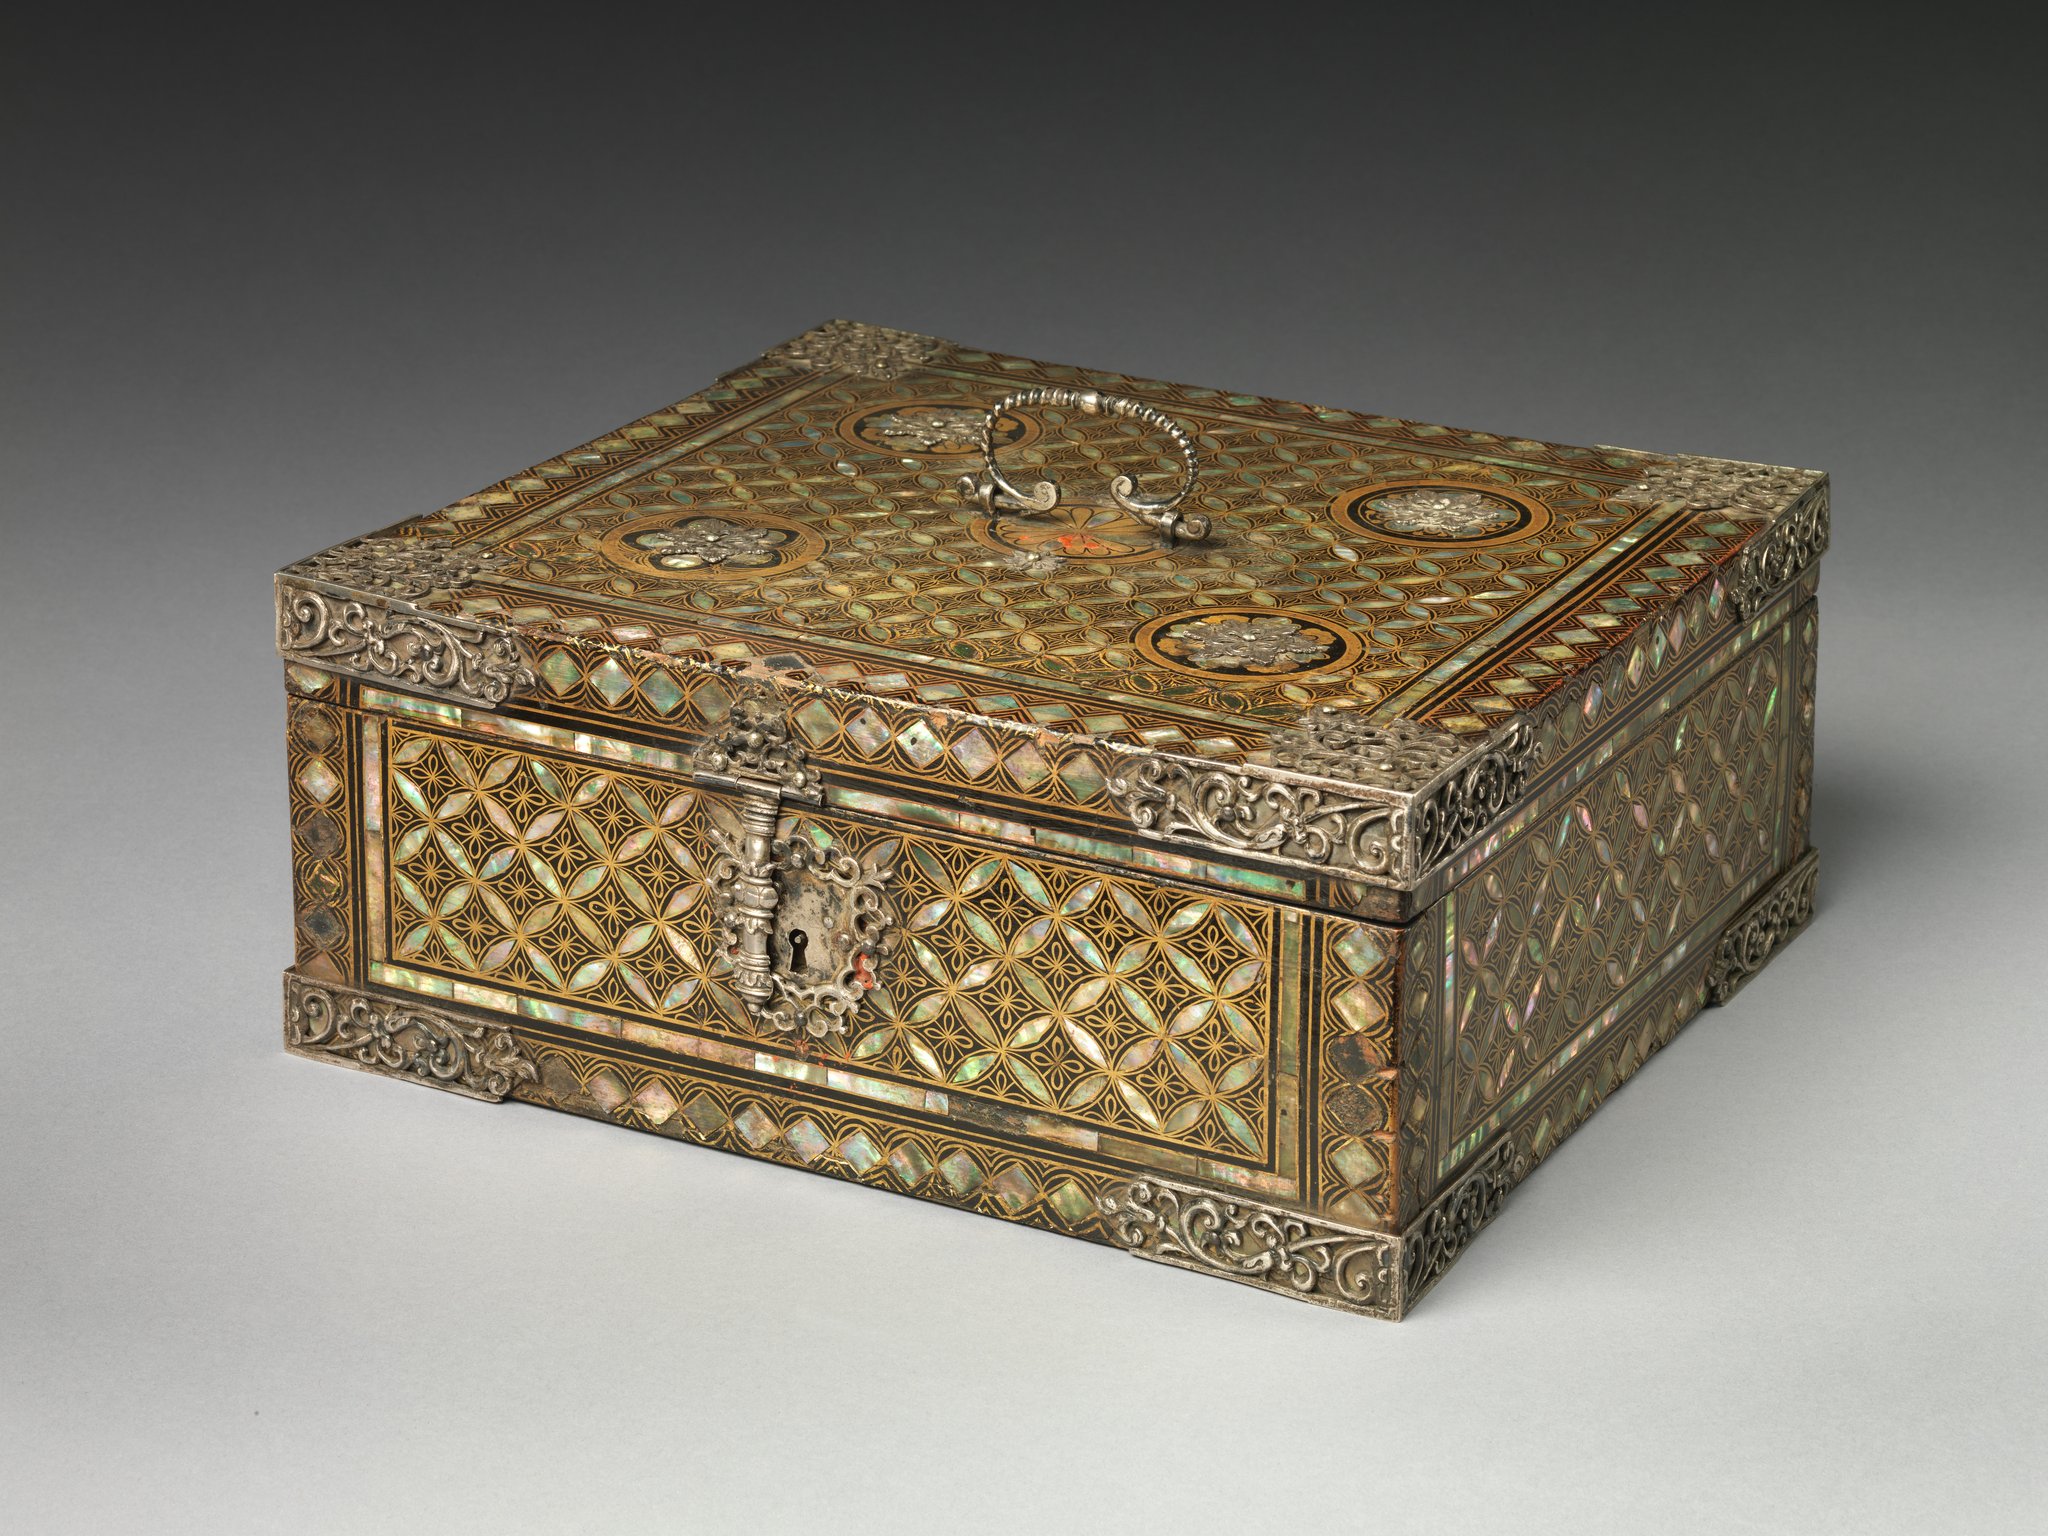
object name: box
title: Portable Nanban Box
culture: japanese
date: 1567-1600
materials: gold, mother of pearl, silver, wood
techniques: hiramakie, inlay, lacquer